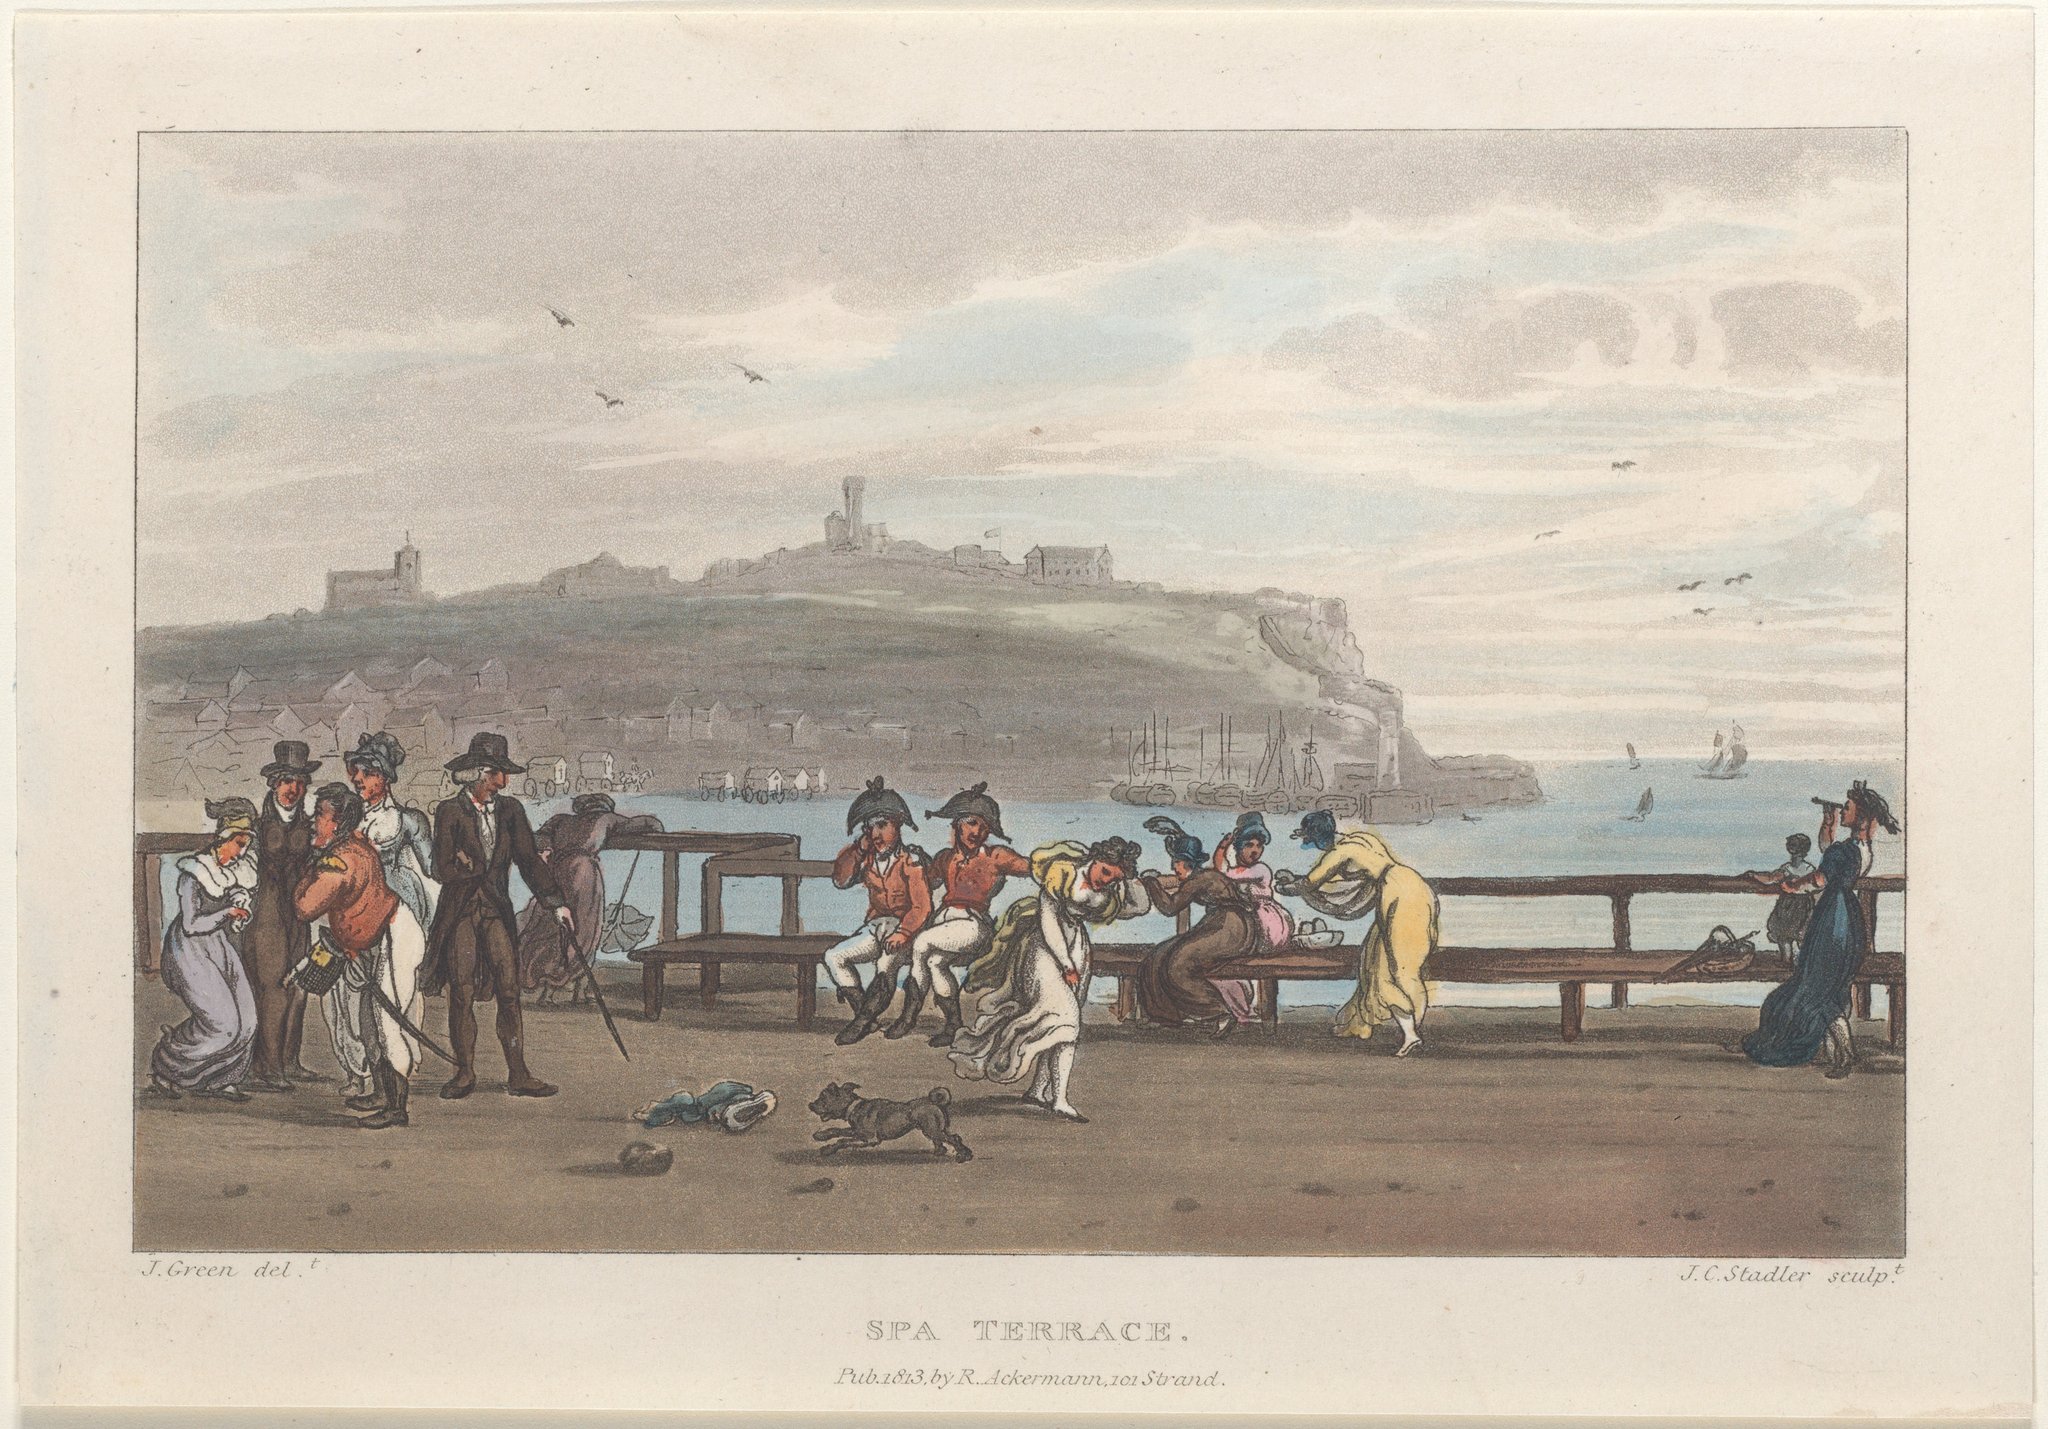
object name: print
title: Spa Terrace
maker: thomas rowlandson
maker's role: artist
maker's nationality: british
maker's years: 1757-1827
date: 1813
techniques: aquatint, etching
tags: men,women,dogs